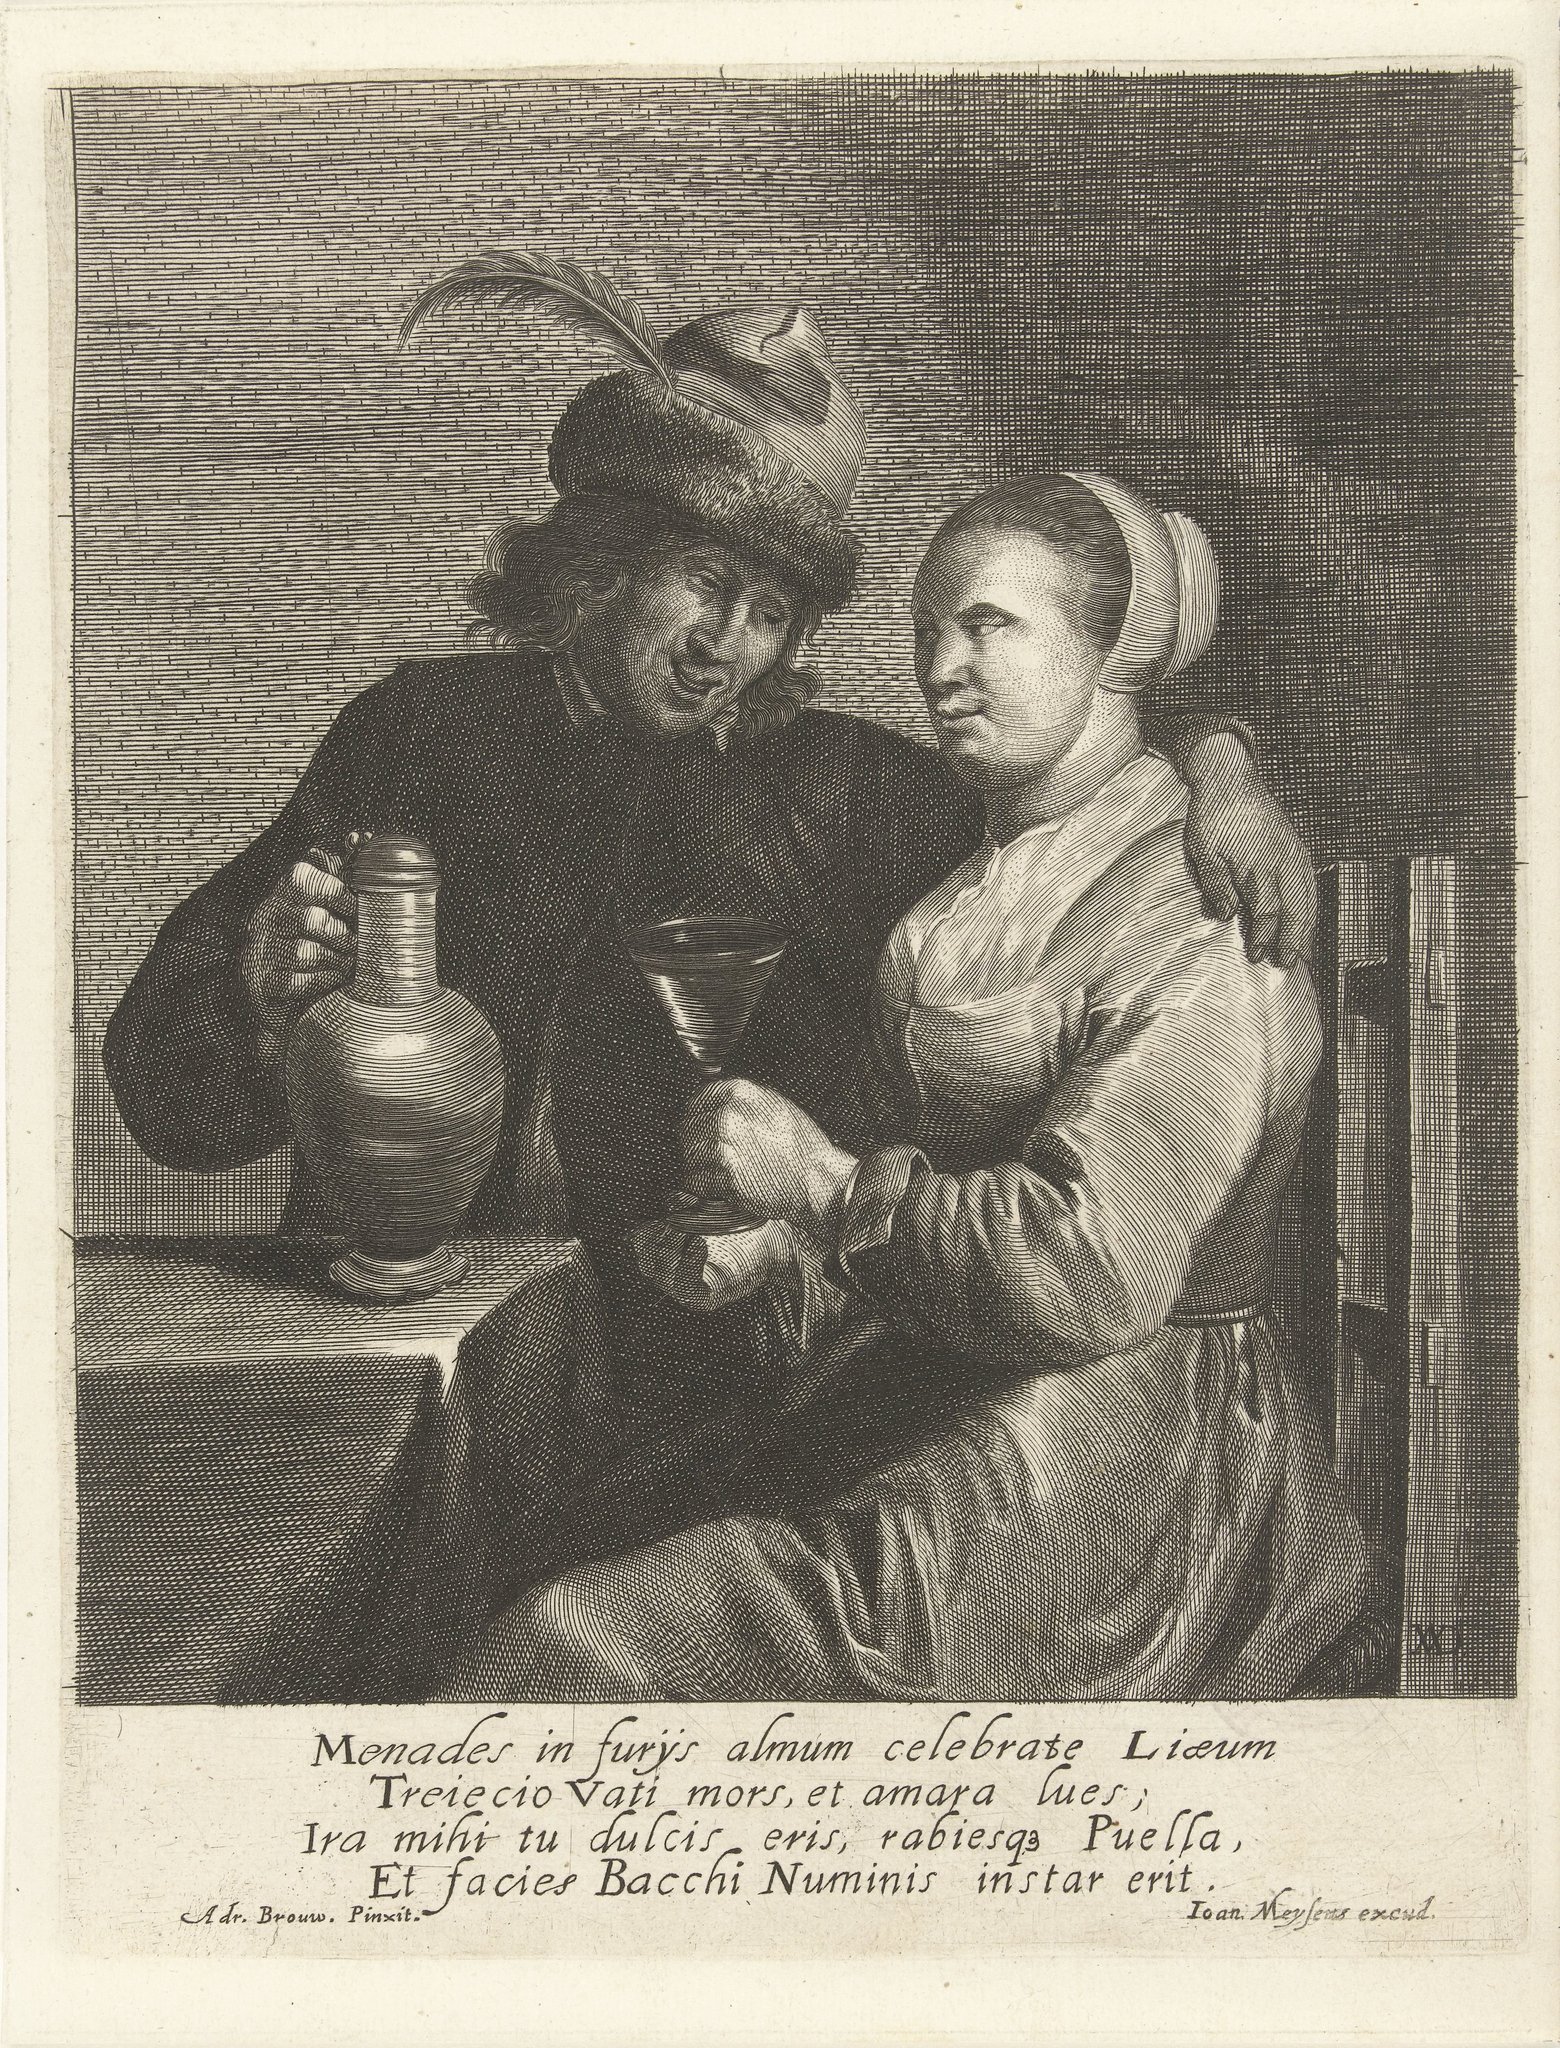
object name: print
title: Man met kan en vrouw met glas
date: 1619-1680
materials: paper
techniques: engraving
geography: southern netherlands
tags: couple of lovers, stimulating drinks (+ foodstuffs in a glass)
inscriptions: collector's mark: Lugt 240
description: Man zittend aan tafel met zijn arm om schouders van vrouw geslagen. In zijn hand een kan, de vrouw houdt een vol glas vast. In ondermarge vers in vier regels Latijns.